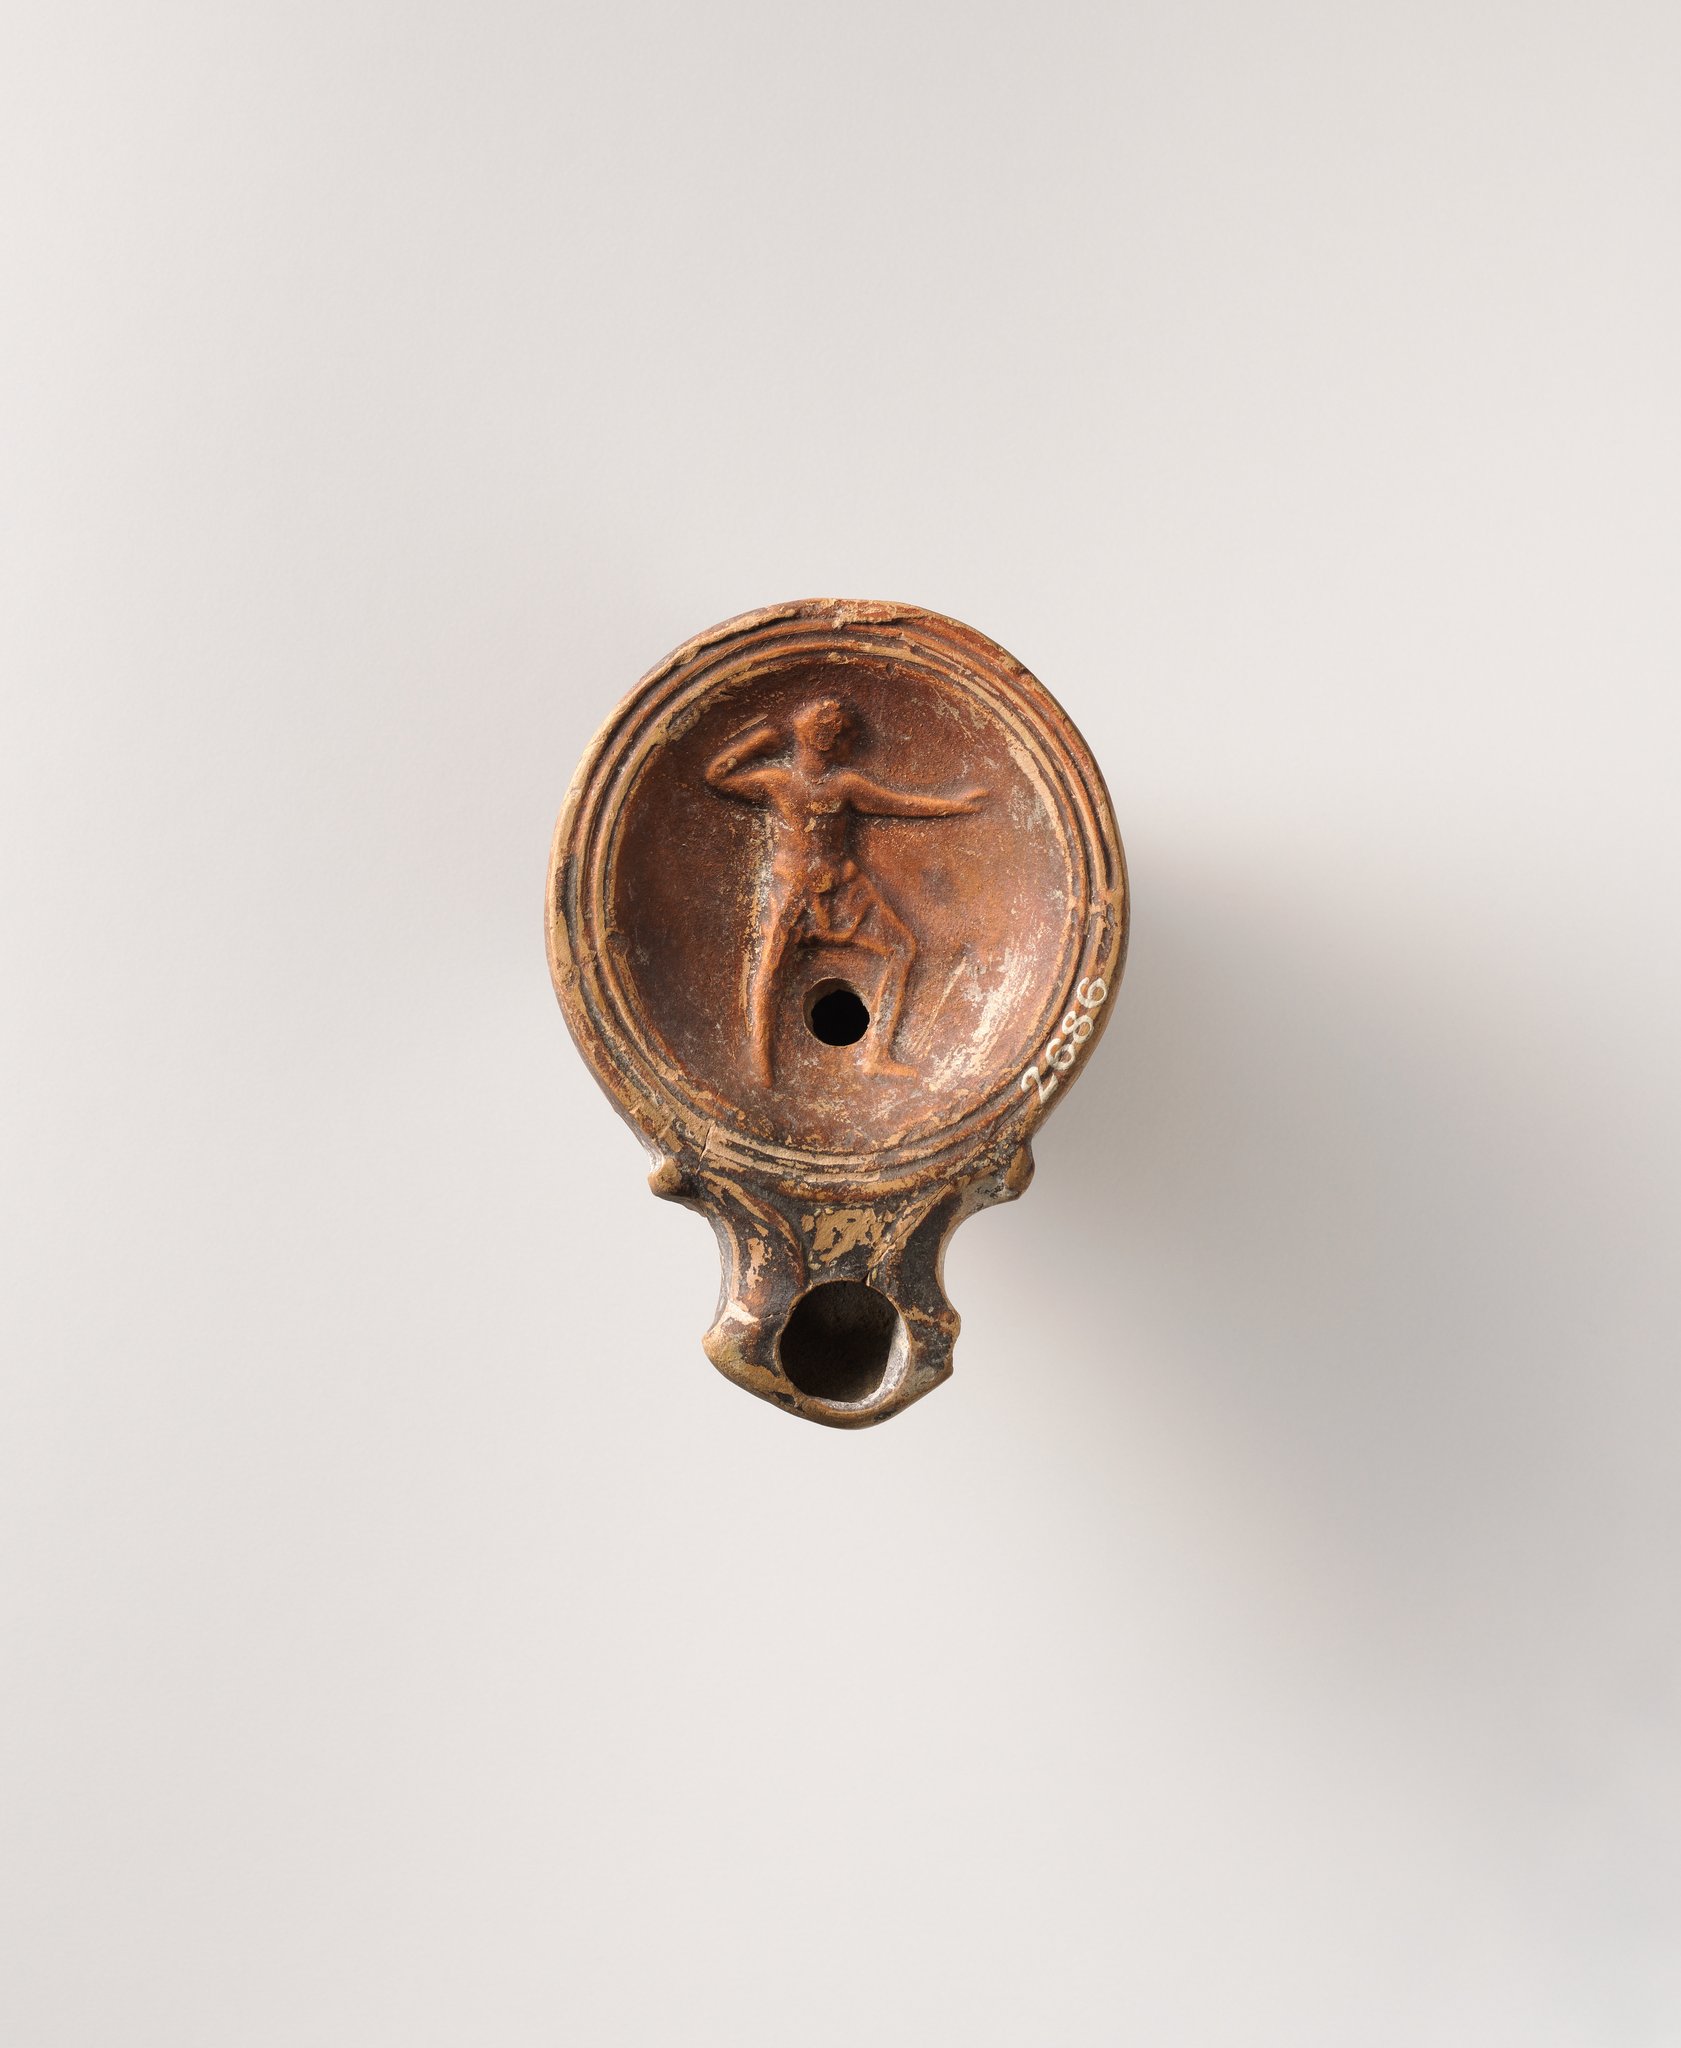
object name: lamp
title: Terracotta oil lamp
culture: roman, cypriot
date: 34 BCE-33 CE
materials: terracotta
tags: men